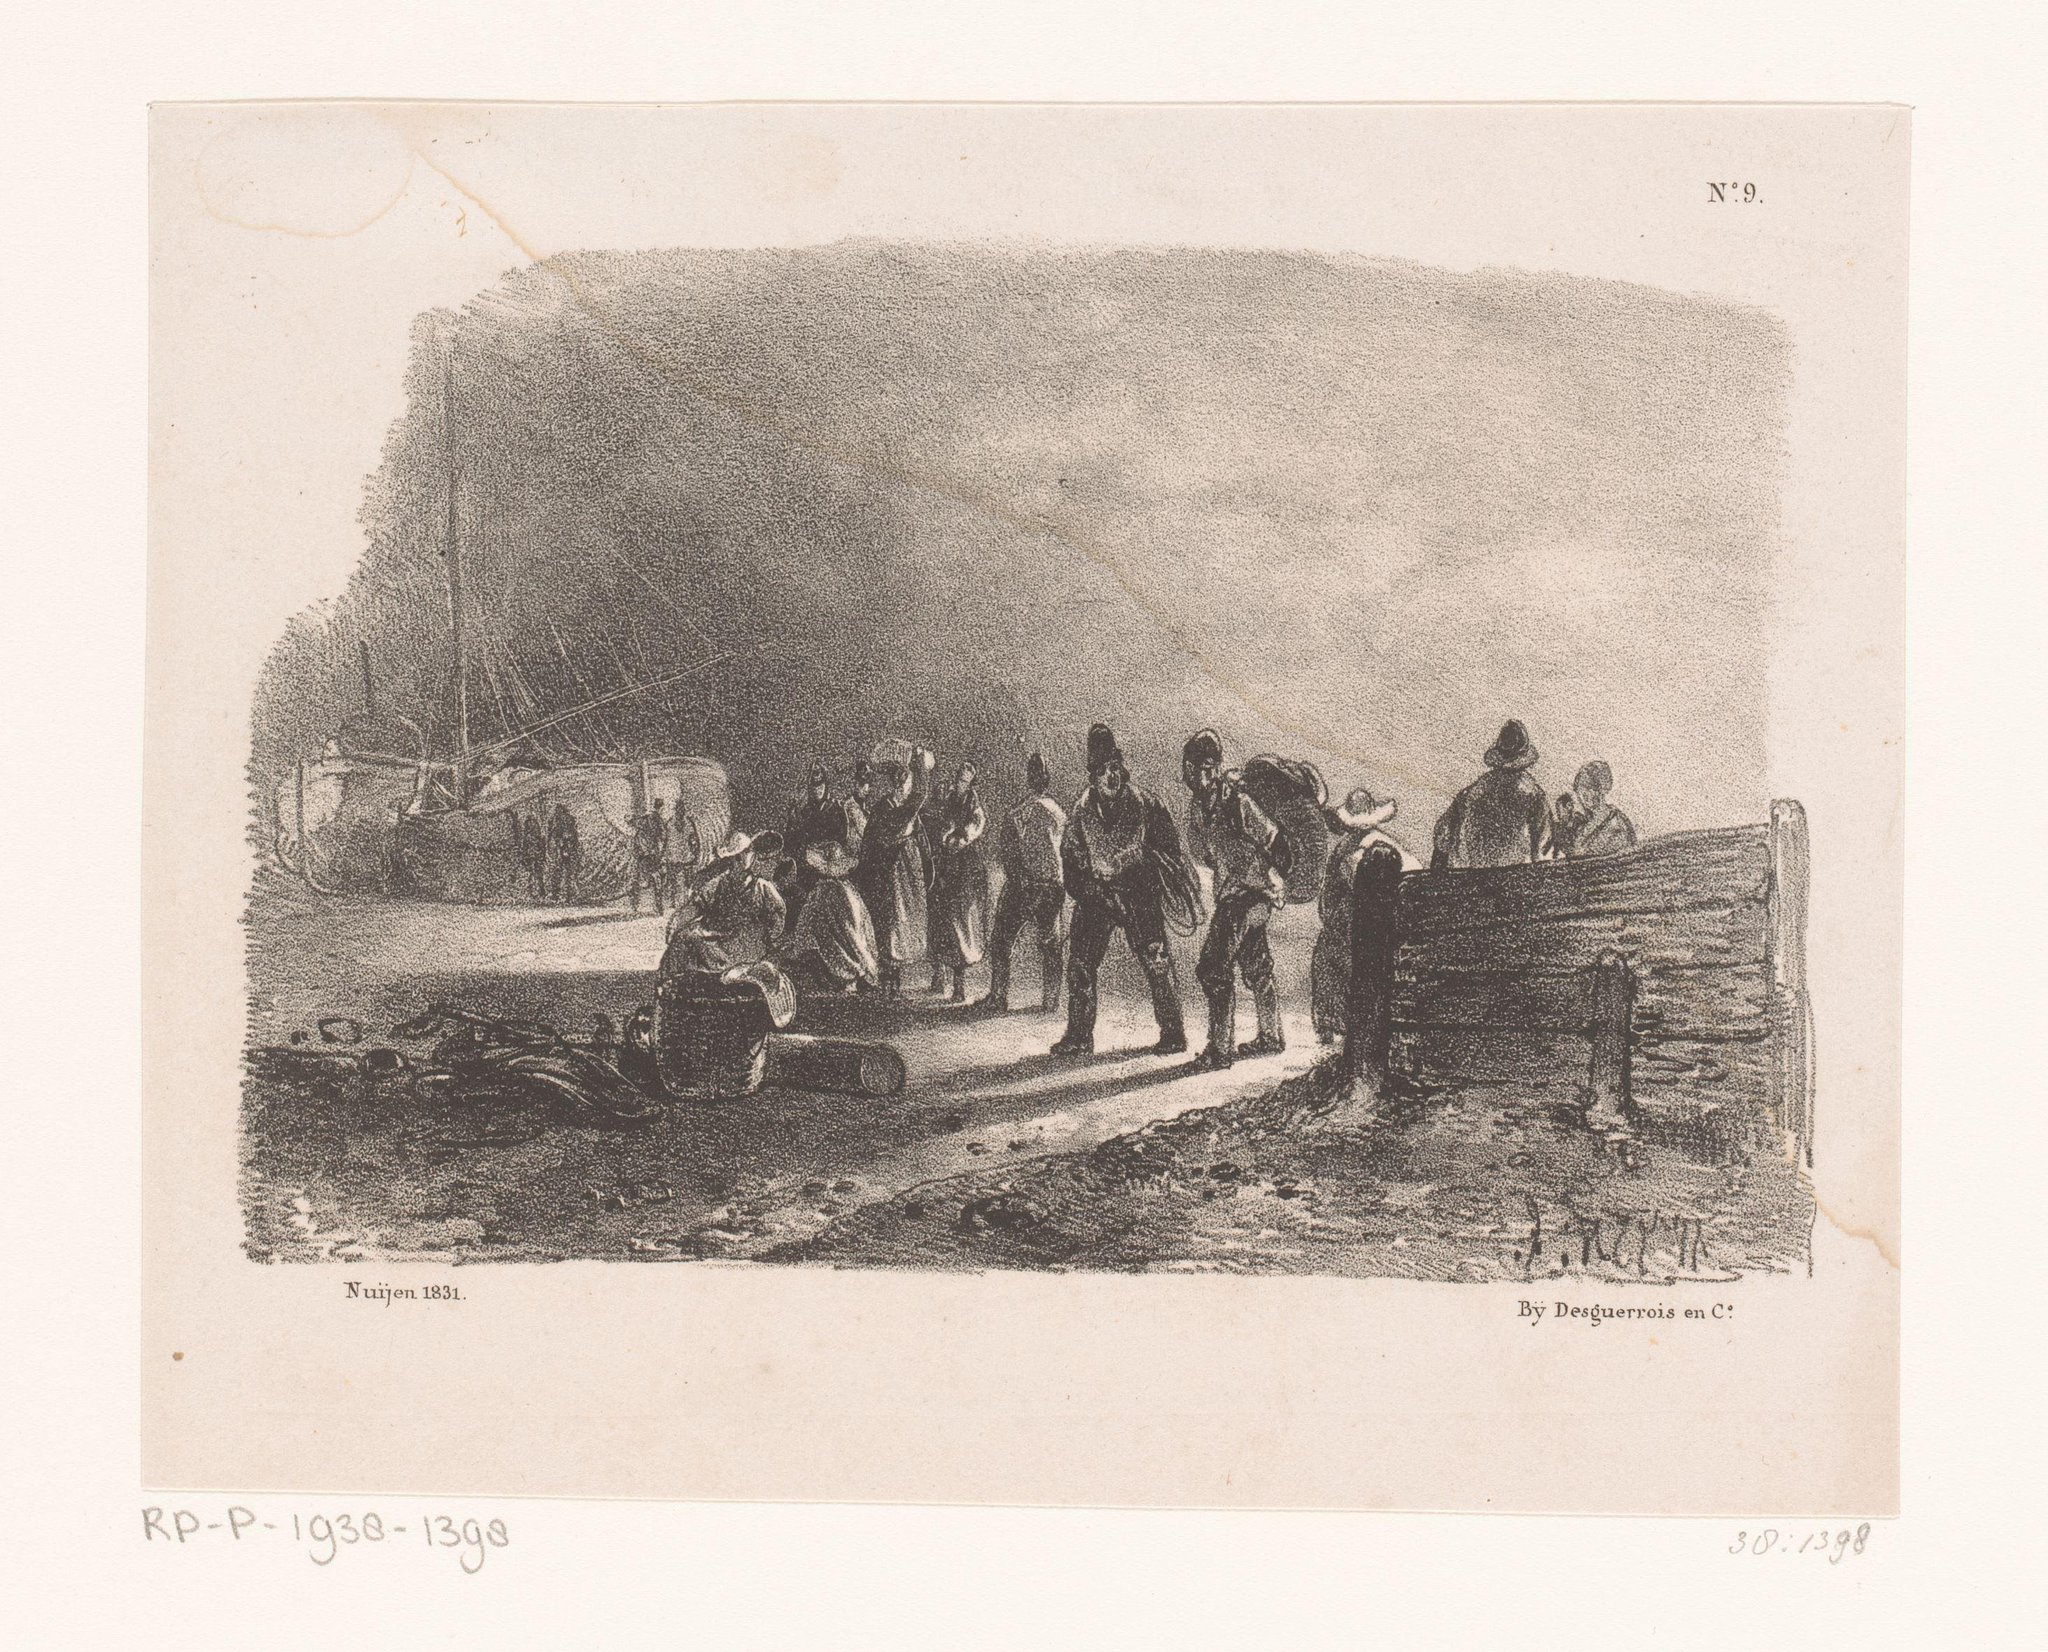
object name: print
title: Thuiskomende vissers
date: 1831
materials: paper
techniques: lithograph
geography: amsterdam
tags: fisherman, boat propelled by man or animal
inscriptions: collector's mark: Lugt 2228, collector's mark: Lugt 2760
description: Een groep vissers aan wal. Links in de achtergrond ligt een vissersboot.